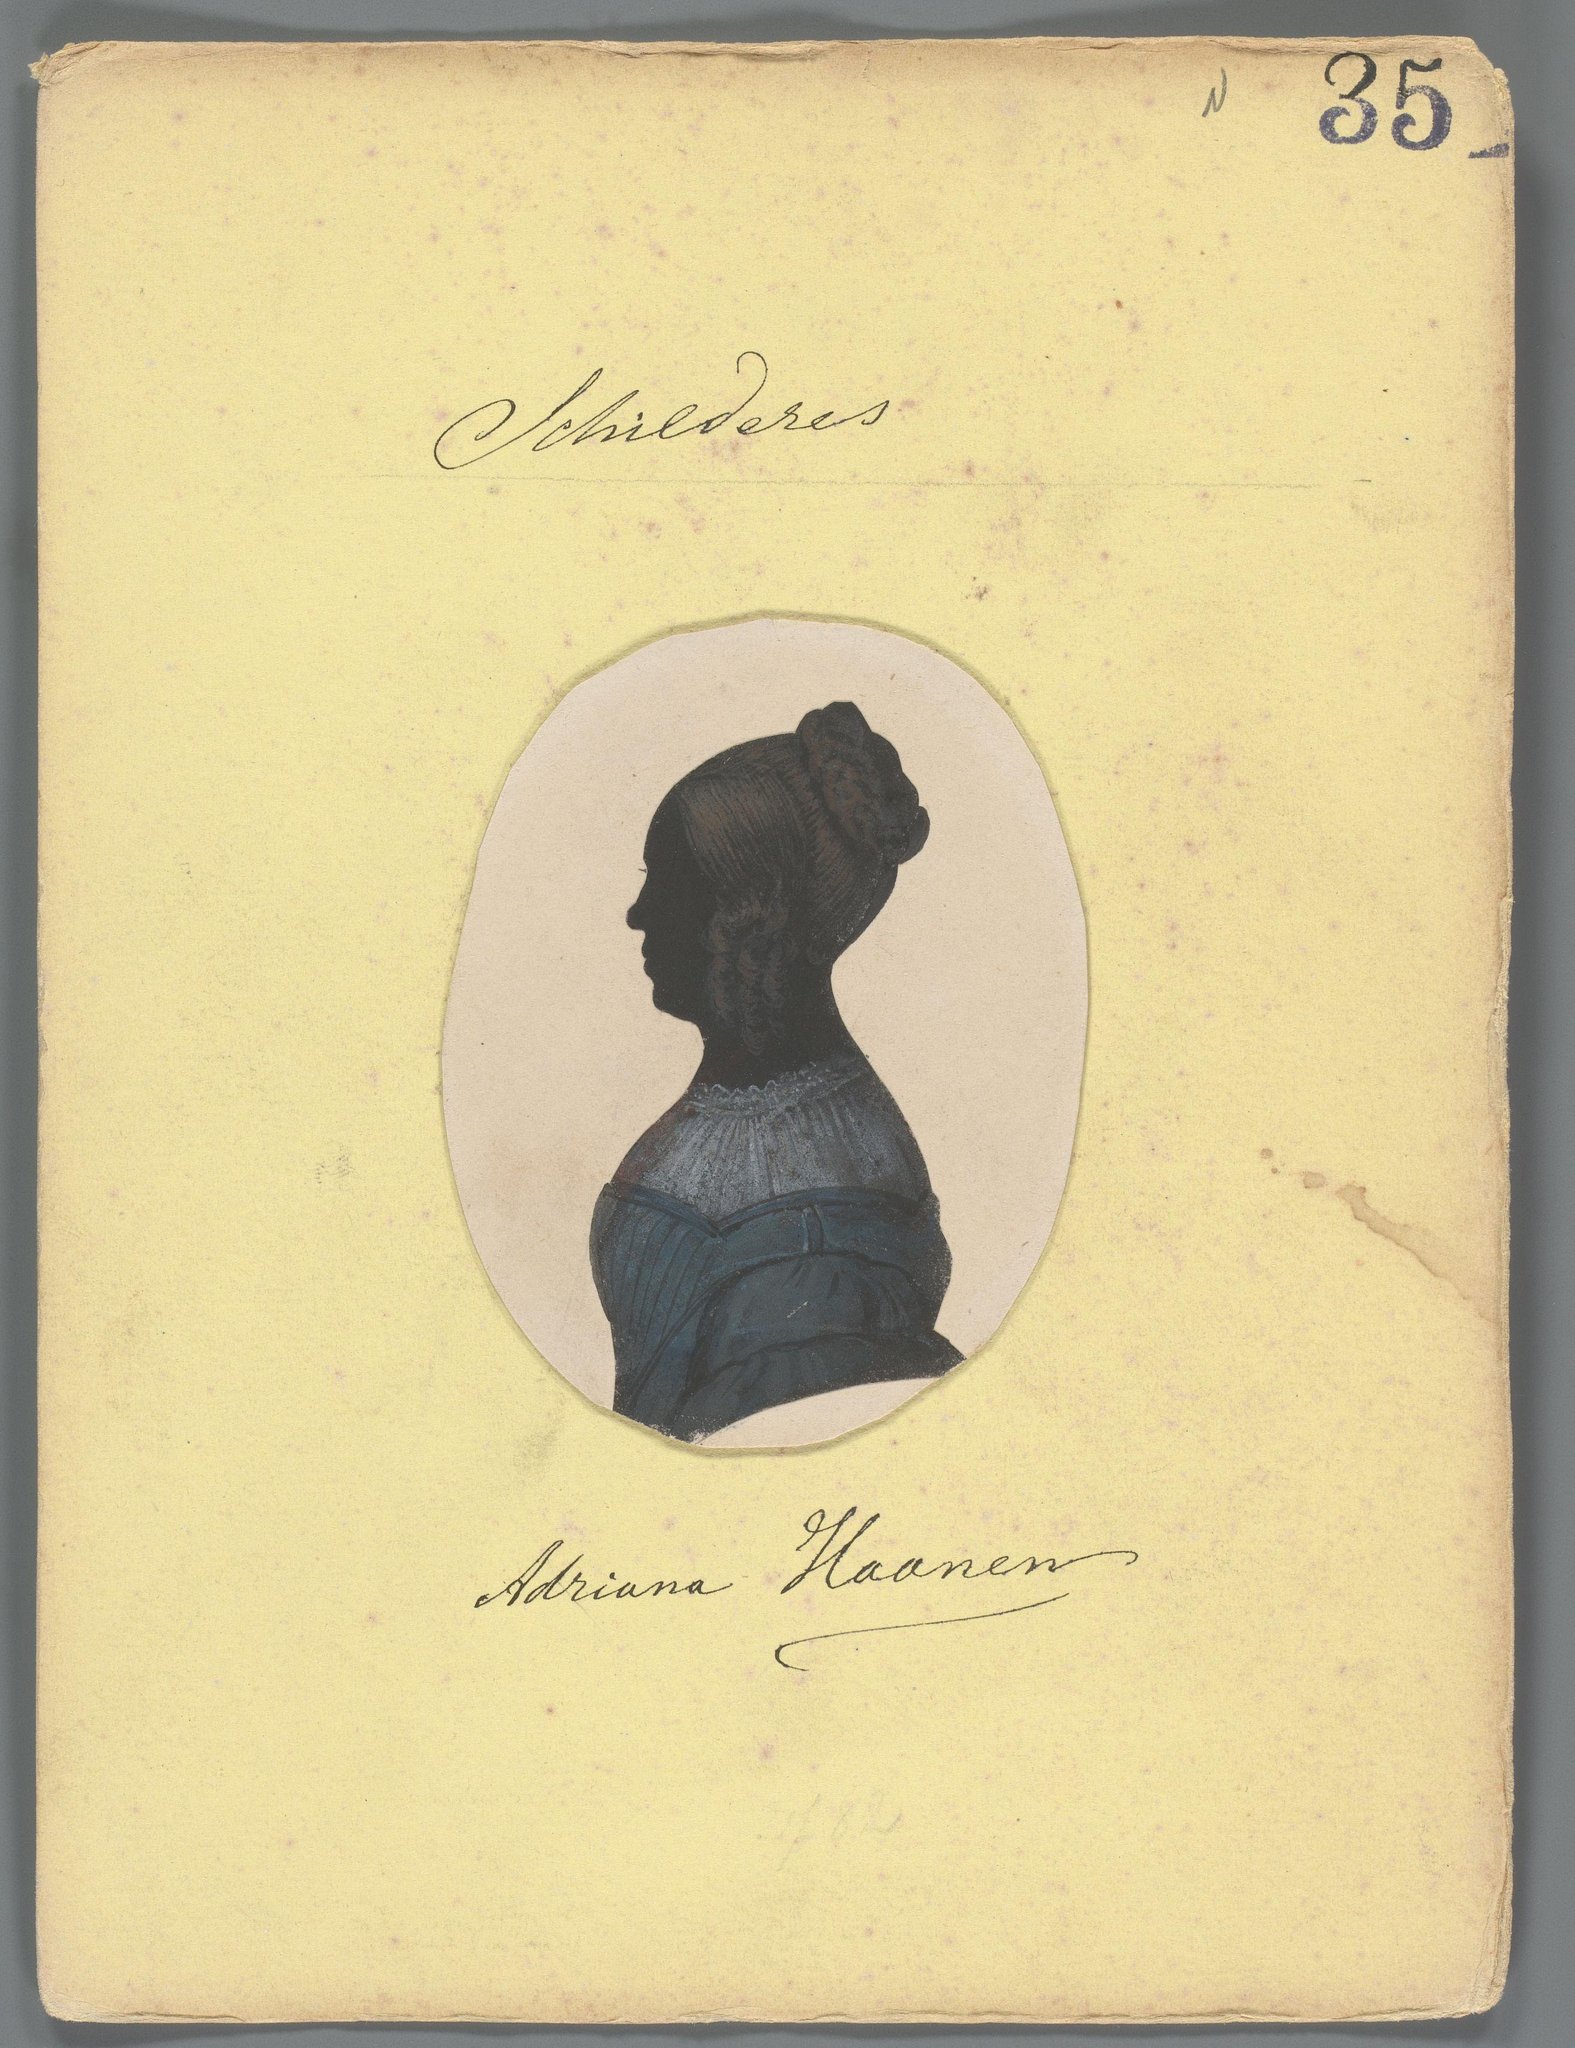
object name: drawing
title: Silhouetportret van Adriana Johanna Haanen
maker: elisabeth alida haanen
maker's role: draughtsman, print maker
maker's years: 1809-1845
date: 1819-1845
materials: ink, paint, paper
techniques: brush, snipping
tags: painter, adriana johanna haanen, historical persons - bb - woman, portrait, self-portrait of painter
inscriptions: inscription: ‘Schilderes’, number: ‘35’, inscription: ‘D. 1341 C. 5146’, number: ‘13948’, inscription: ‘Adriana Haanen’, collector's mark: ‘Ex-libris van Beresteyn’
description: Met onder het portret de handtekening van de geportretteerde.